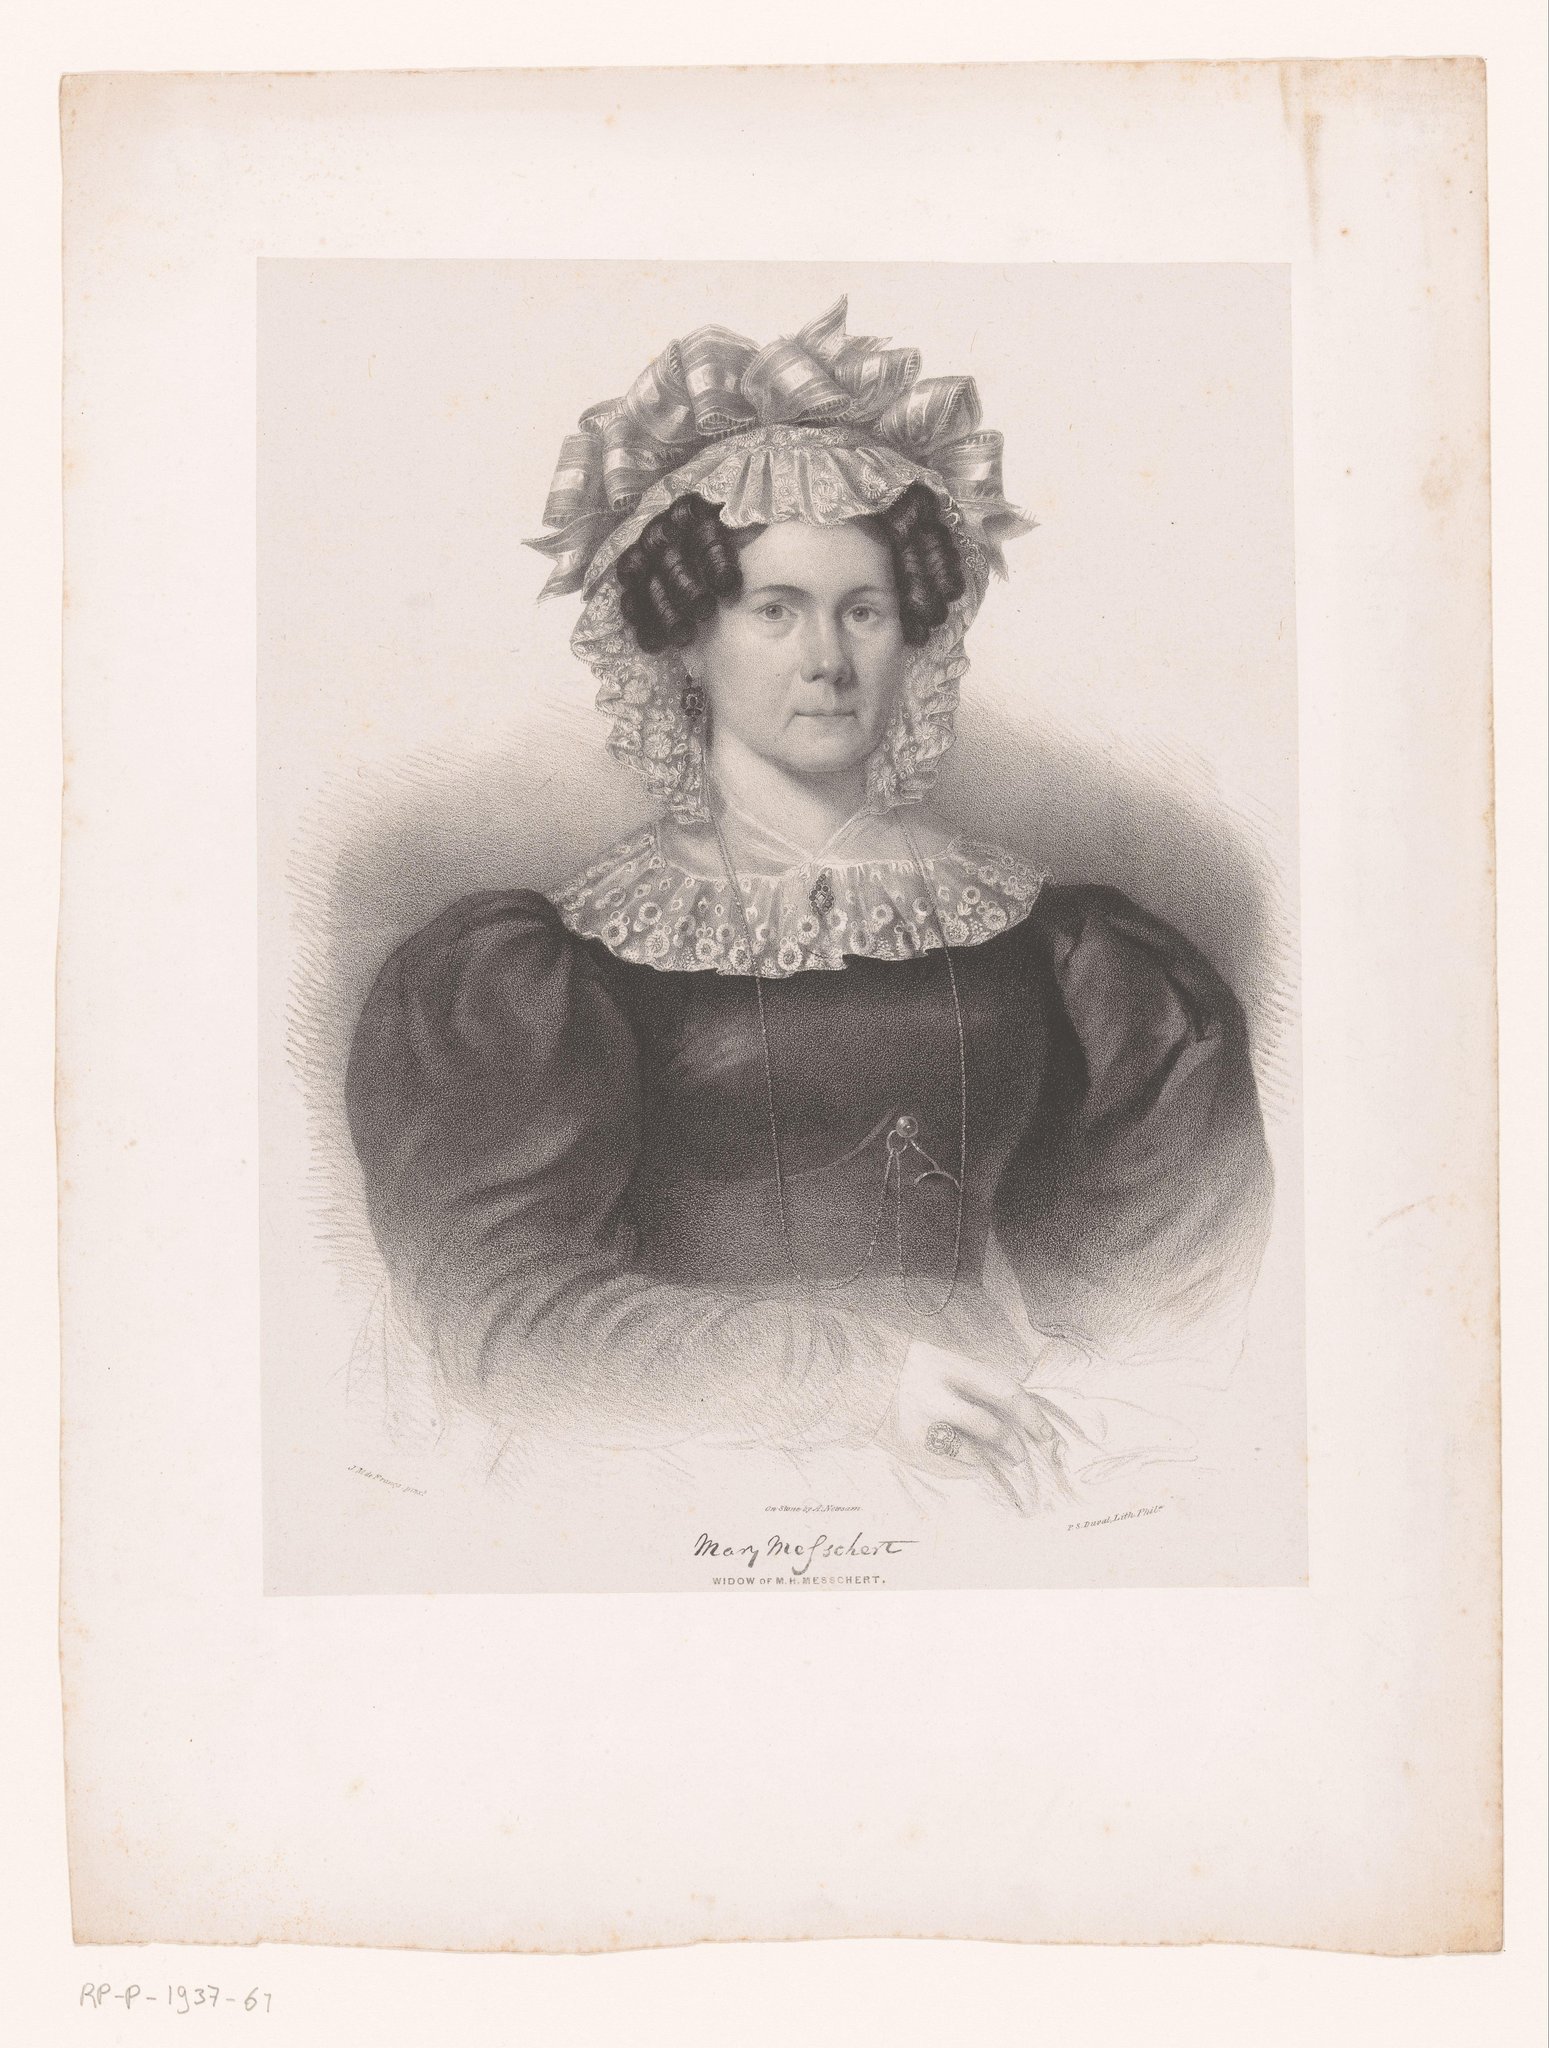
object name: print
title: Portret van Mary Messchert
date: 1833-1864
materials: paper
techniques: lithograph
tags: historical persons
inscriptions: inscription: ‘Mary Messchert / widow of M.H. Messchert.’, collector's mark: Lugt 2228, signature: ‘P.S. Duval, Lith. Phila’, signature: ‘J.M. de França pinxt.’, signature: ‘On Stone by A. Newsam’